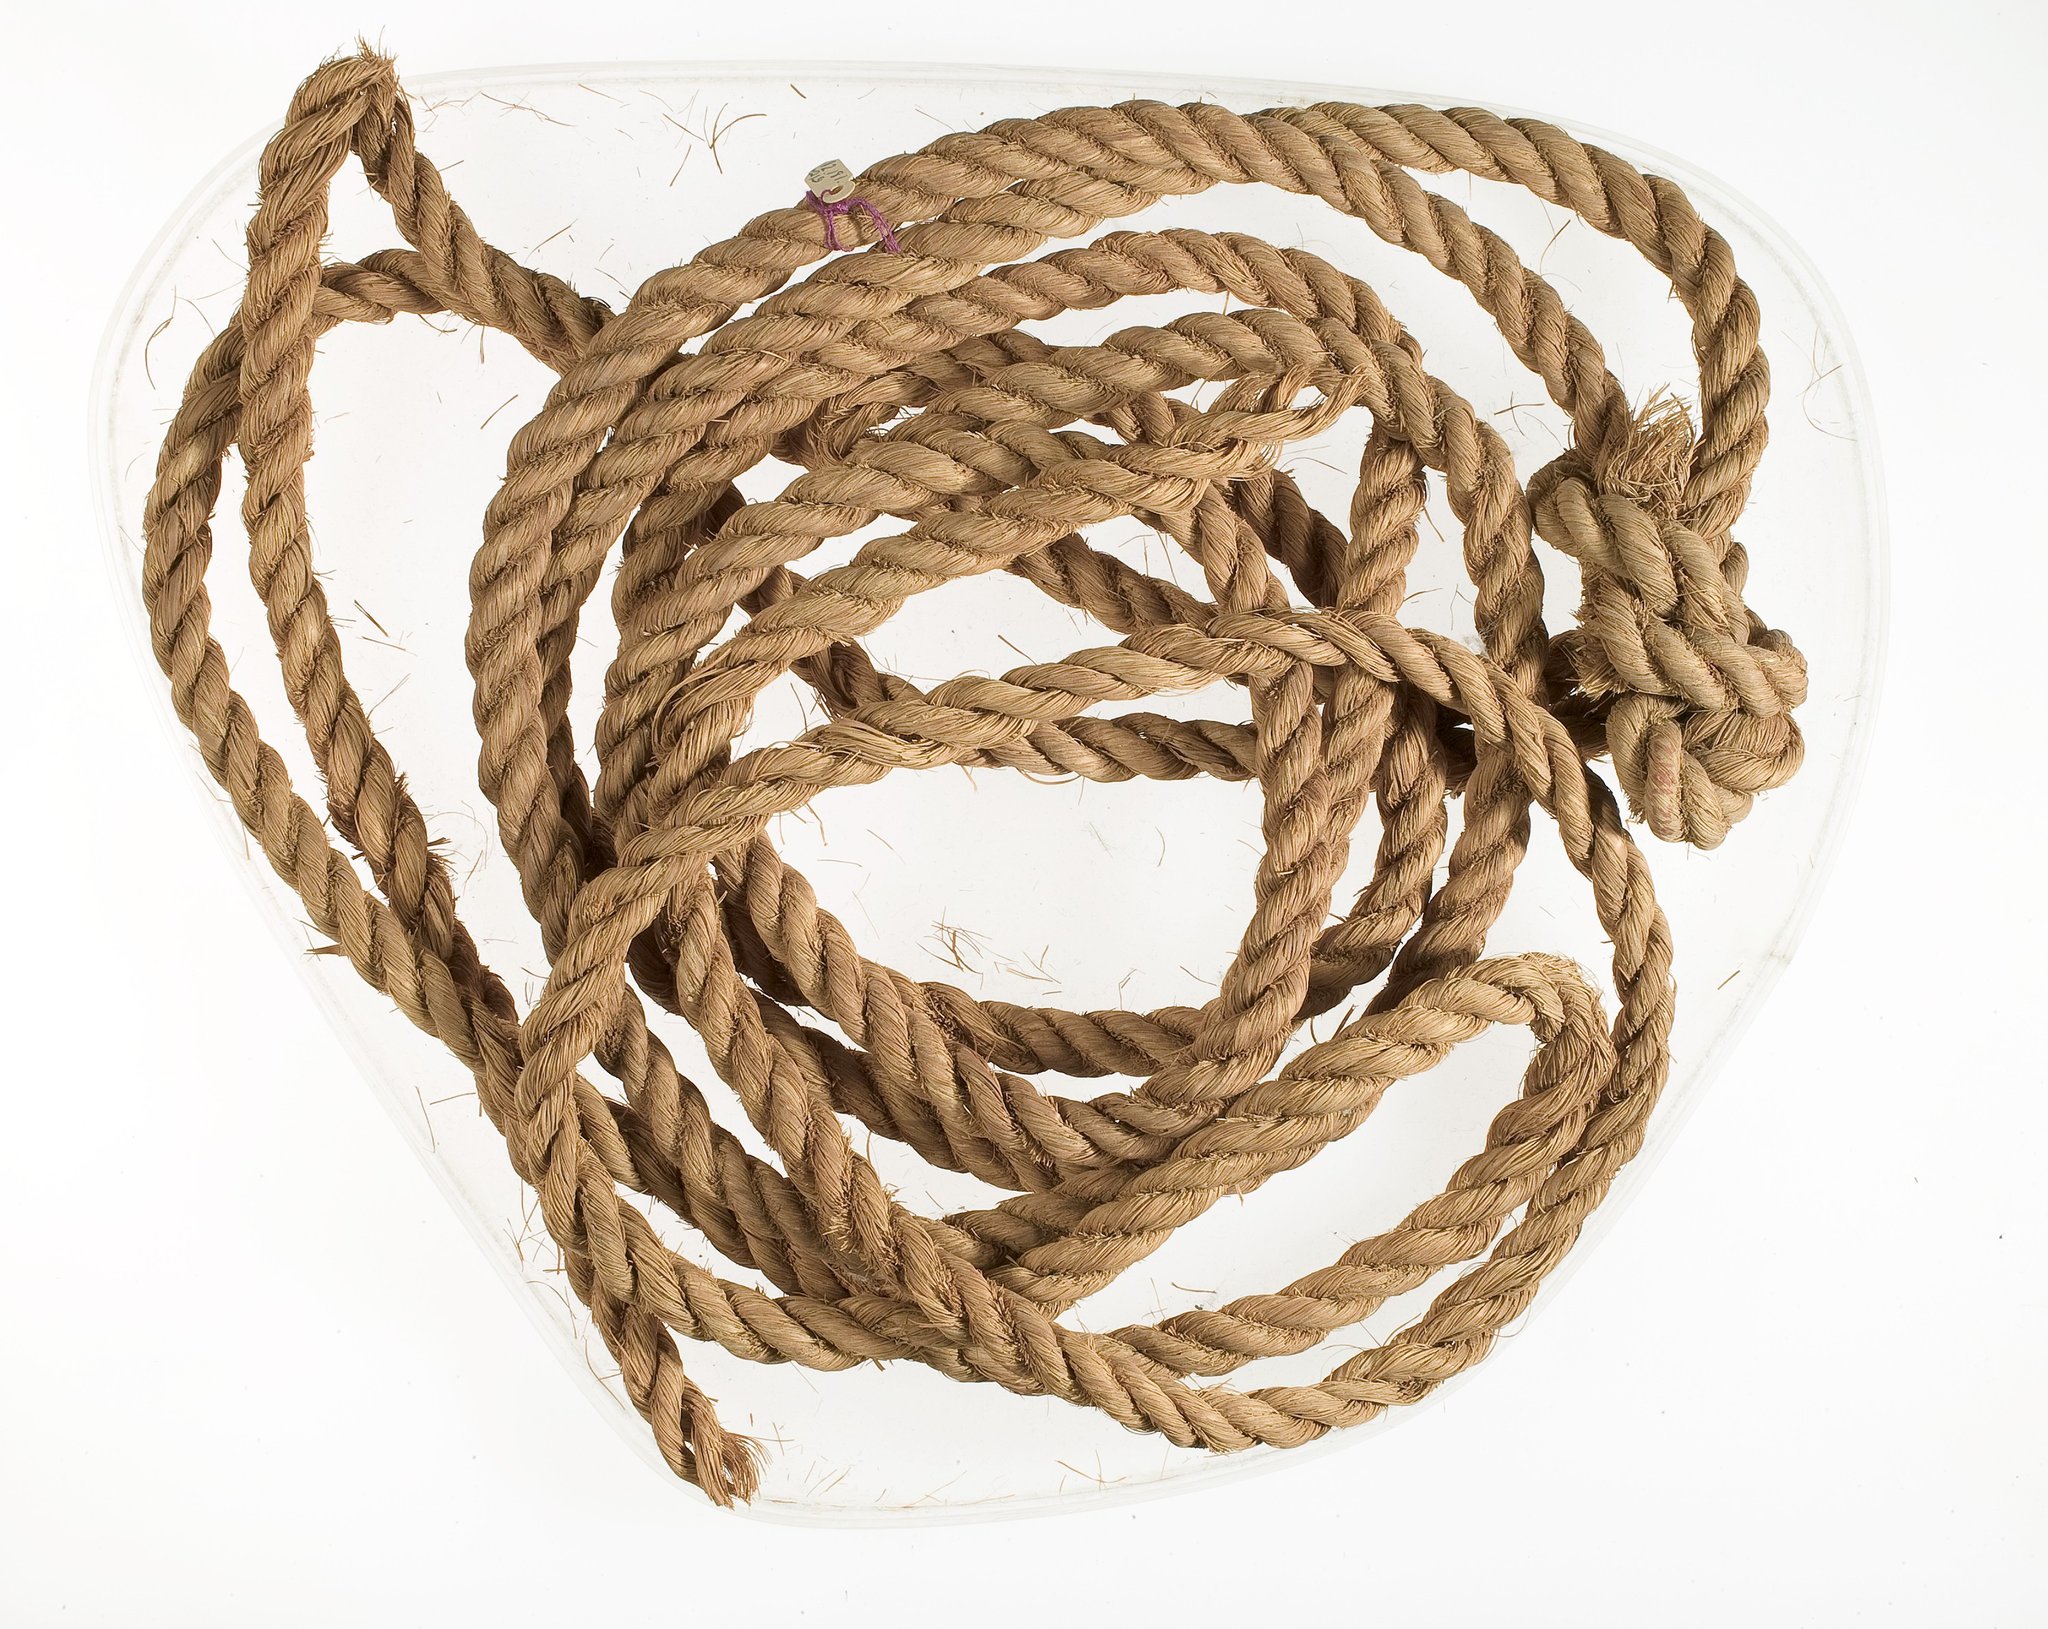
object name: rope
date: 1550-1295 BCE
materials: fiber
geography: egypt